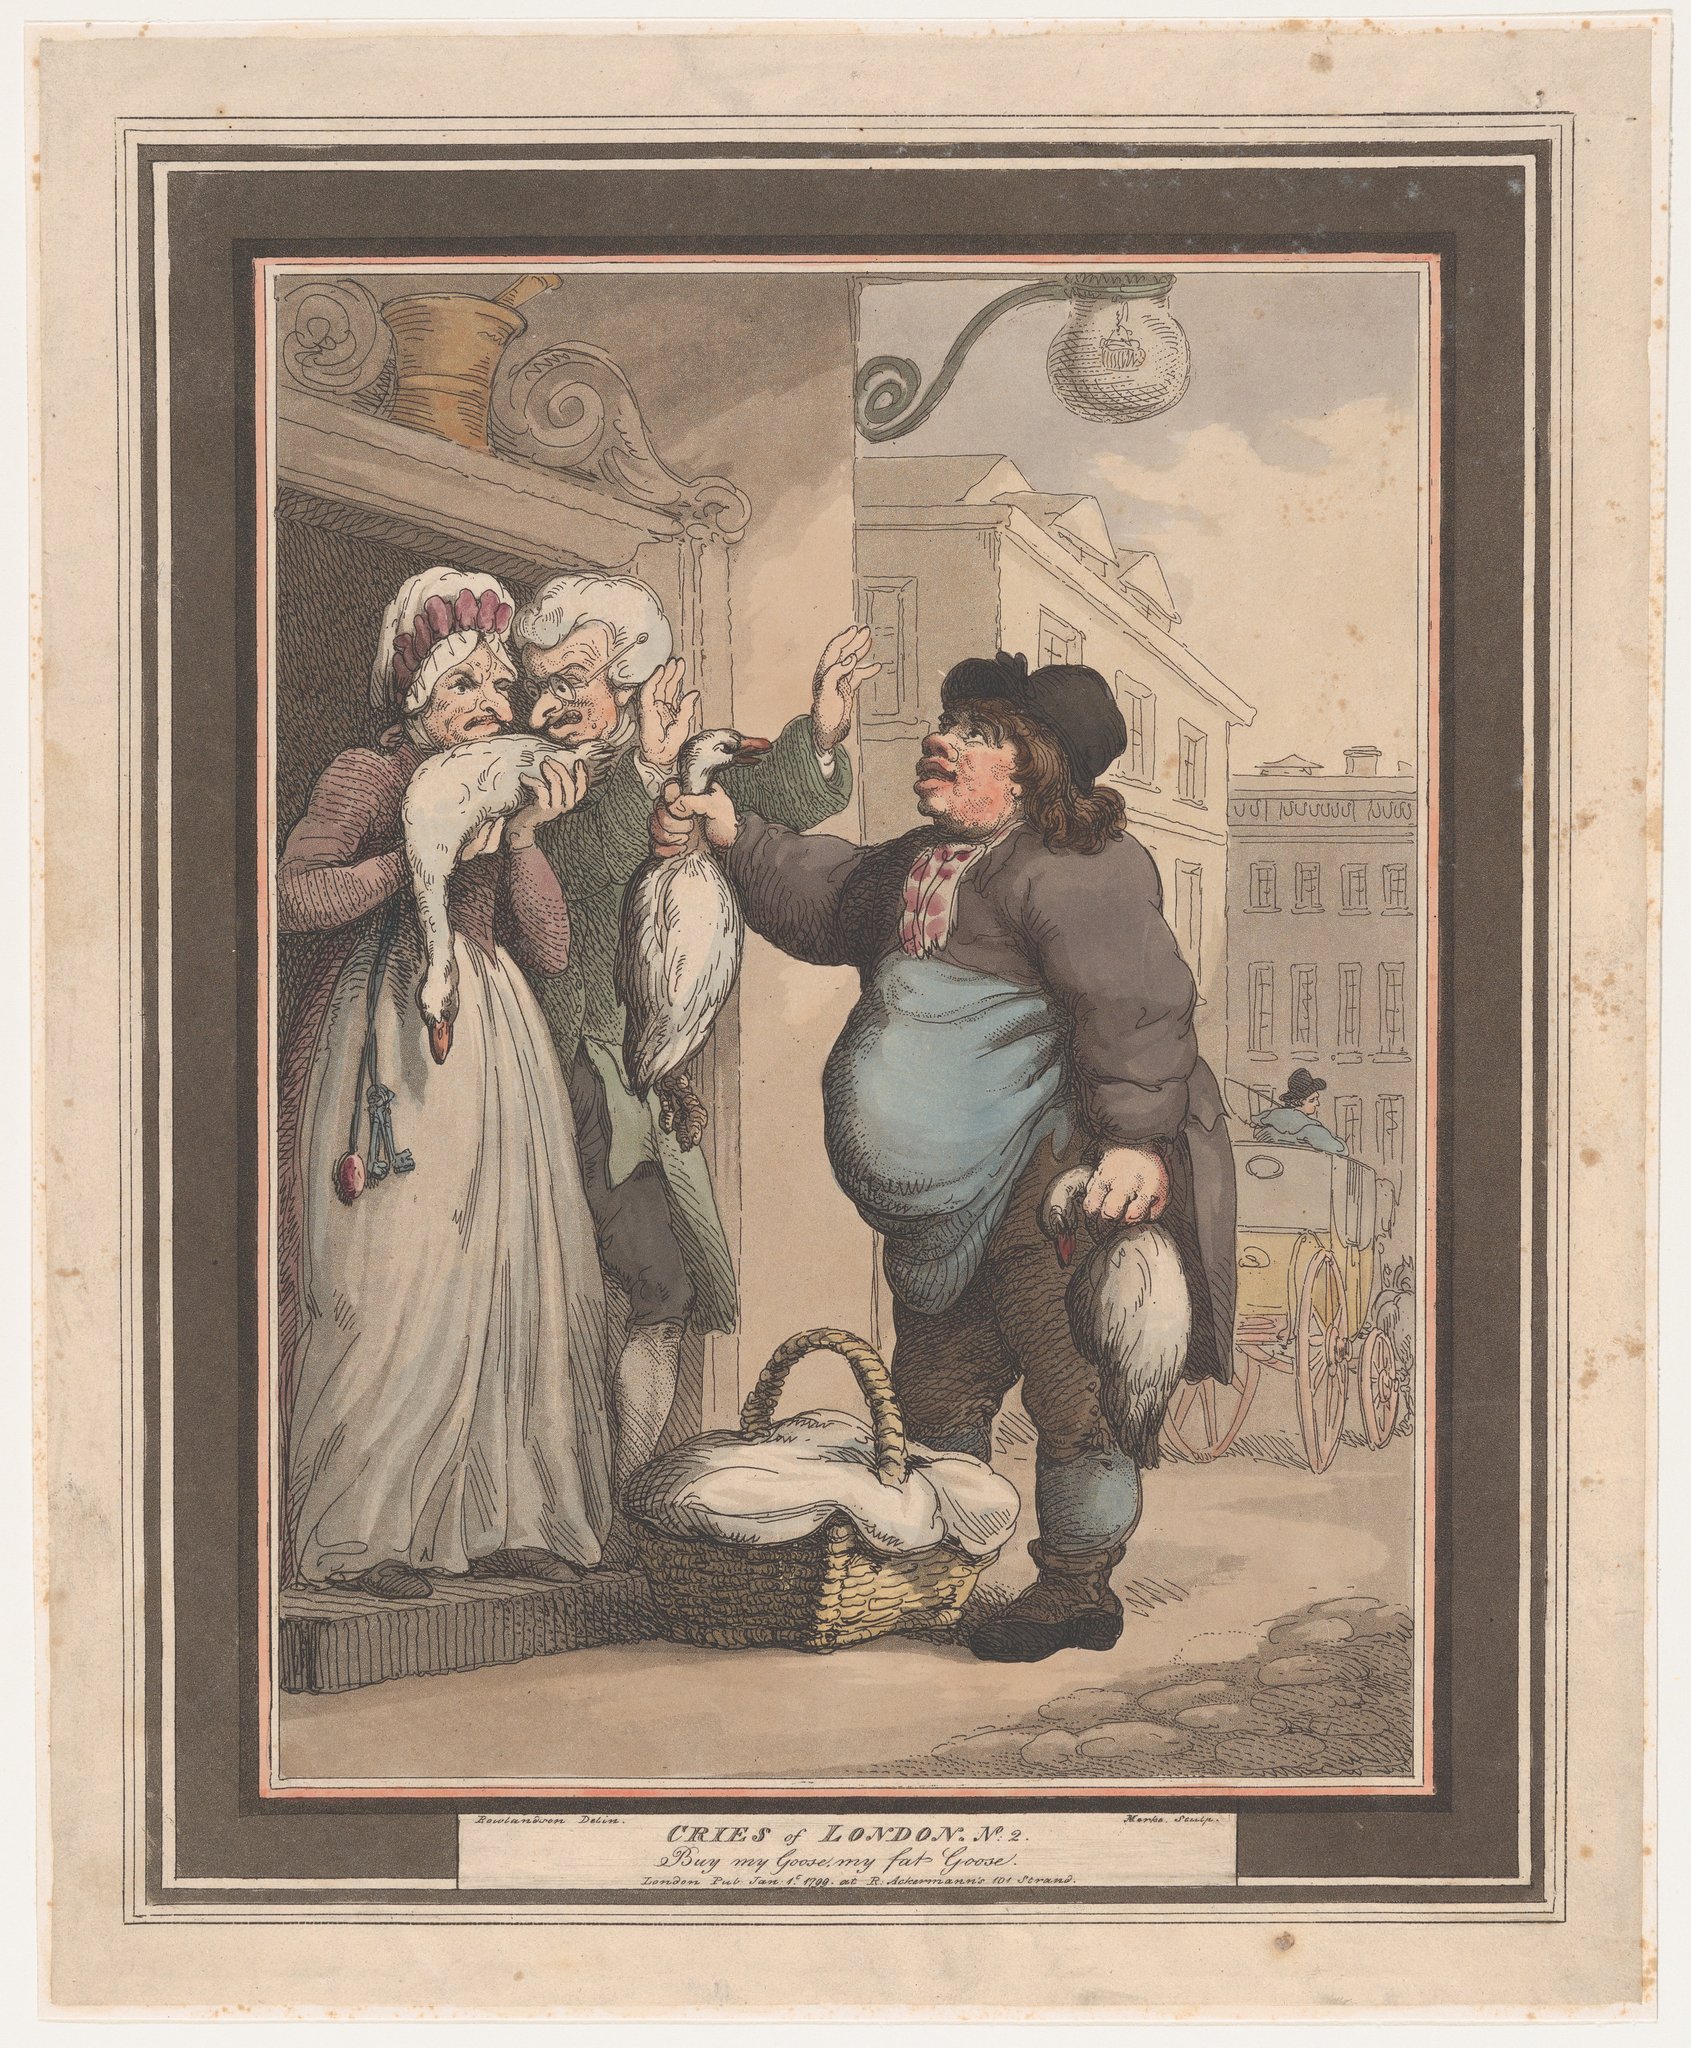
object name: print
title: Cries of London, No. 2: Buy my Goose, my fat Goose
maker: henri merke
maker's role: artist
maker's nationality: swiss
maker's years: 1760-1820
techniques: aquatint, etching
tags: birds,men,women